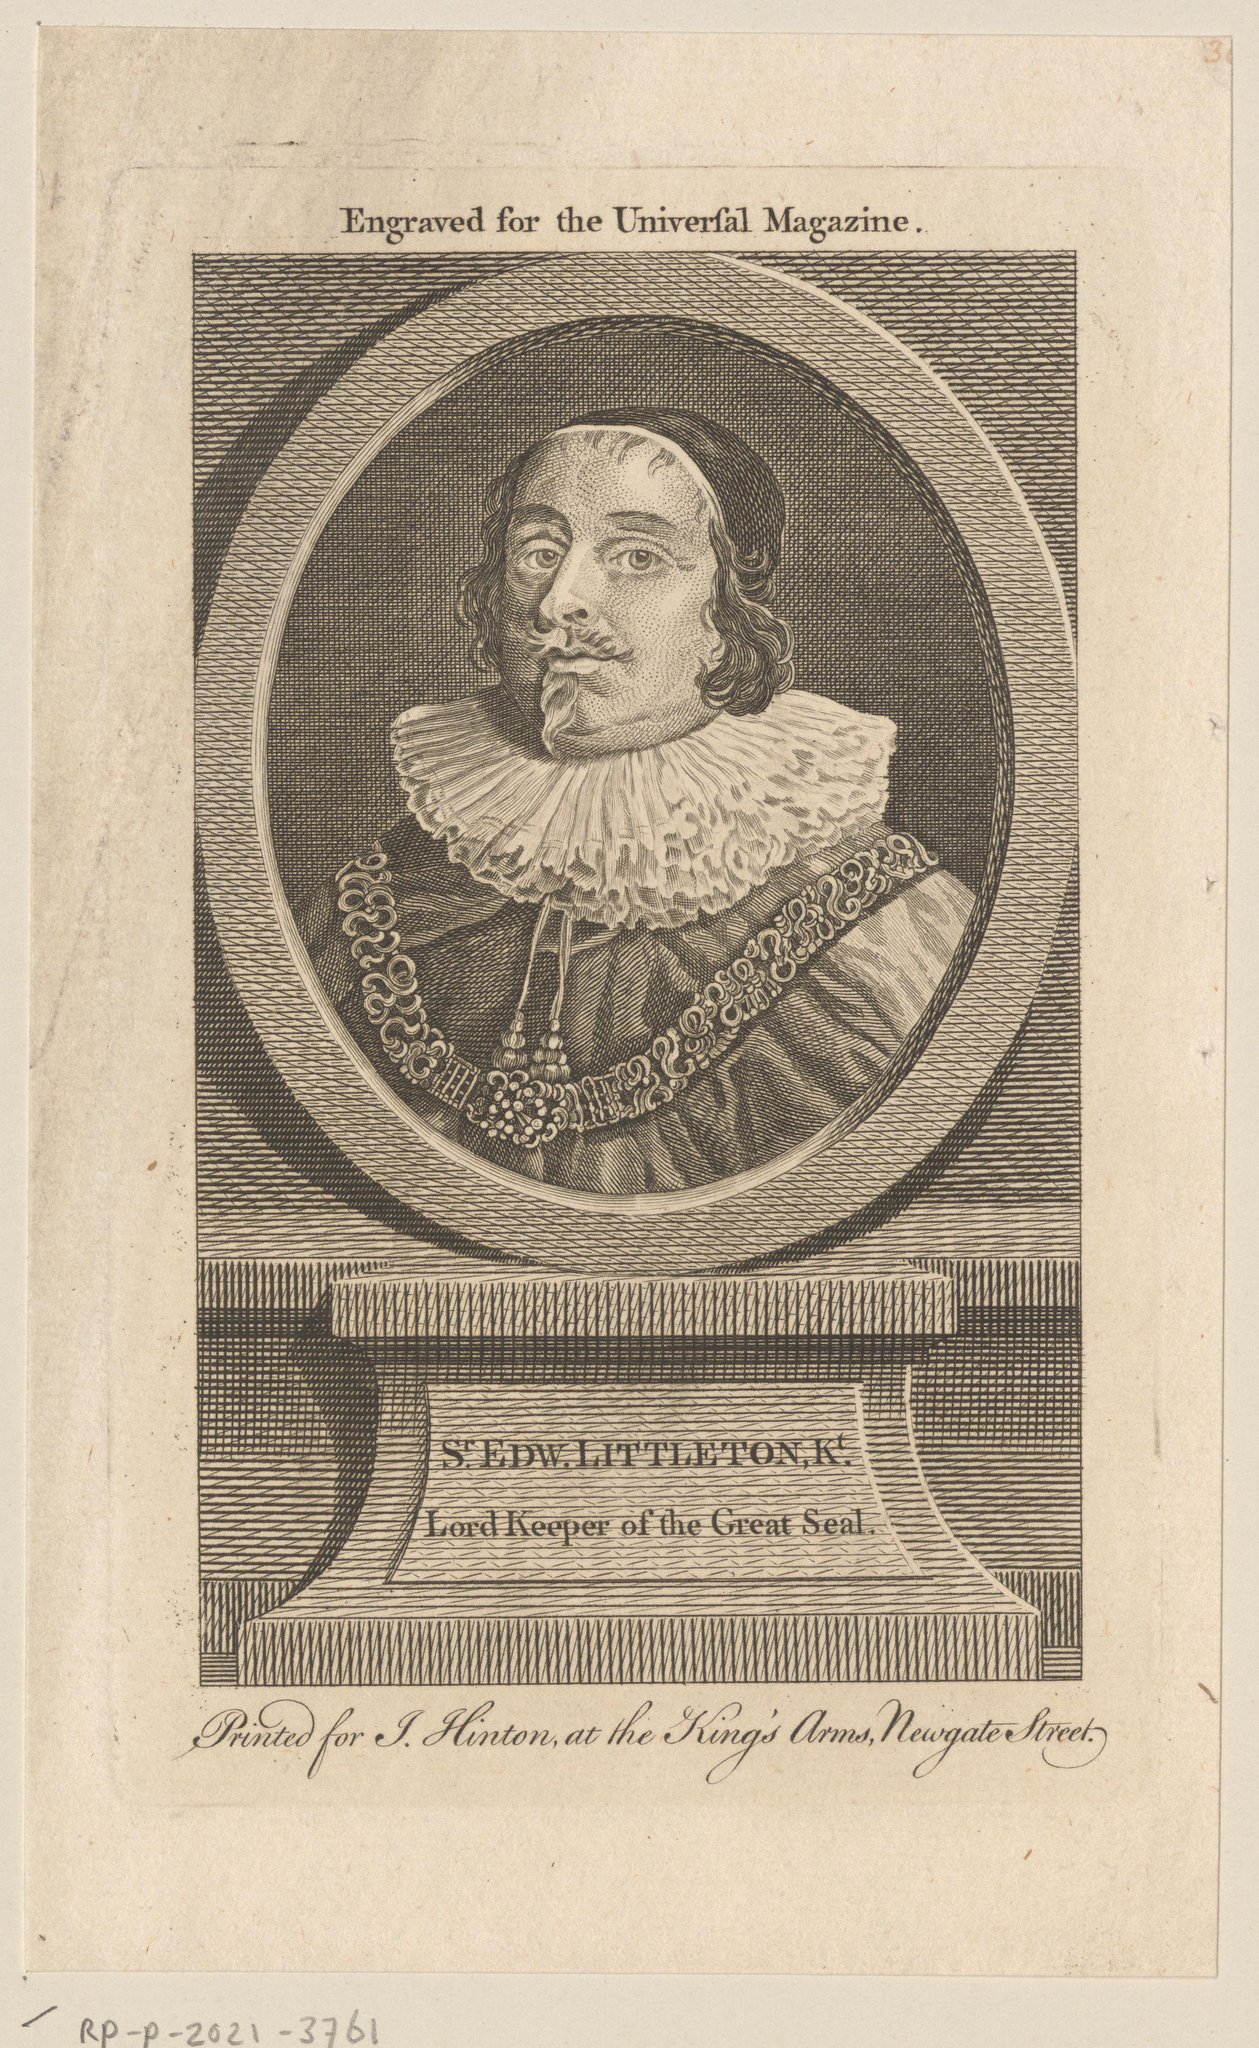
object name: print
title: Portret van Edward Littleton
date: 1747-1781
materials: paper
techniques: engraving, etching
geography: london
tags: politician, ornament ~ medallion, historical persons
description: Prent komt uit een editie van The Universal Magazine.